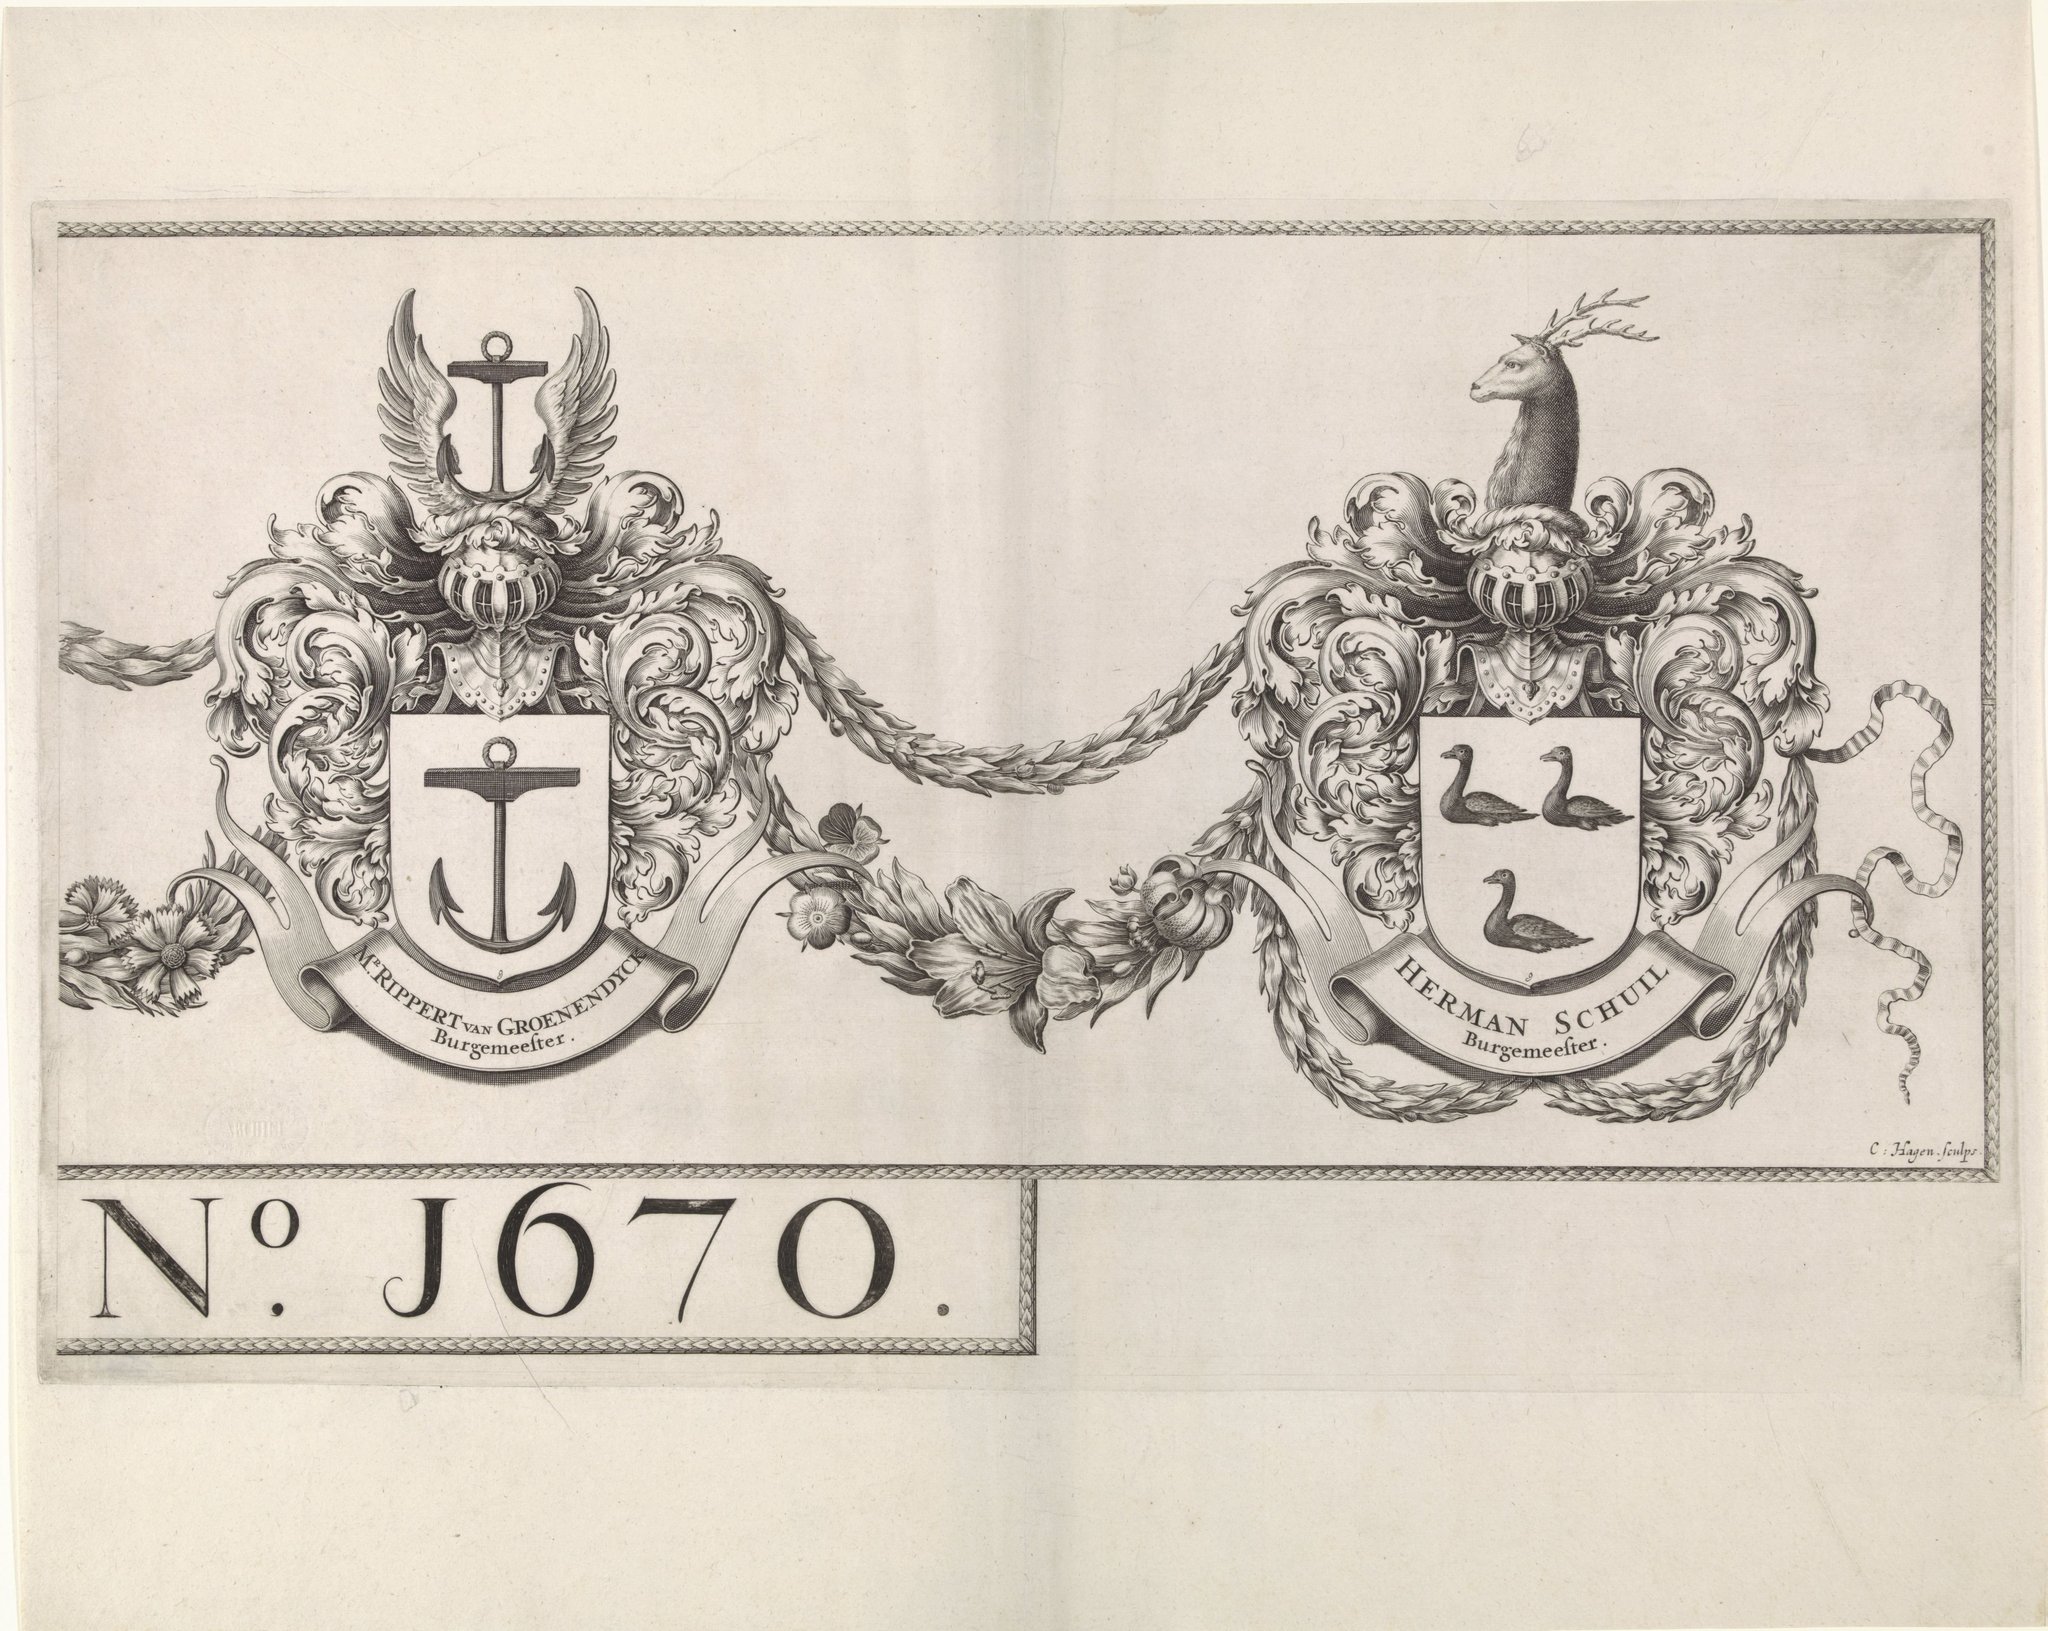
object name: print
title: Bovenkant van de rand van de Grote Hagen (rechterblad)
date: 1675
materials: paper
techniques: engraving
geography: amsterdam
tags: armorial bearing, heraldry, leiden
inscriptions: check stamp: ‘Archief Ministerie van Oorlog Afdeeling Genie’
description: Deze prent is oorspronkelijk bedoeld als onderdeel van de rand van de zogenaamde Grote Hagen, een wandkaart van Leiden uit 1675. Deze wandkaart bestaat uit een plattegrond van Leiden met daaromheen een rand (met boven de titel en de wapens van de stad en de burgemeesters, langs de zijkanten afbeeldingen van gebouwen in de stad en onder een stadsprofiel). De plattegrond is gedrukt van vier platen, de rand van veertien. Hoewel het jaartal 1670 in de titel staat en de wapens aan de bovenkant van de vier in 1670 zittende burgemeesters zijn, blijkt uit archiefonderzoek dat deze wandkaart pas in 1675 voor het eerst is gedrukt en uitgegeven (zie documentatie voor meer informatie). Voor een digitaal gemonteerde versie van de hele rand zie RP-P-2016-1124. Voor een digitaal gemonteerde versie van de bovenkant van de rand zie koepelrecord. Voor een digitaal gemonteerde versie van de onderkant van de rand zie RP-P-AO-10-18A-B. Voor een digitaal gemonteerde versie van een latere druk van de plattegrond zie RP-P-AO-10-18. Voor een digitaal gemonteerde versie van de Kleine Hagen zie RP-P-AO-10-81.